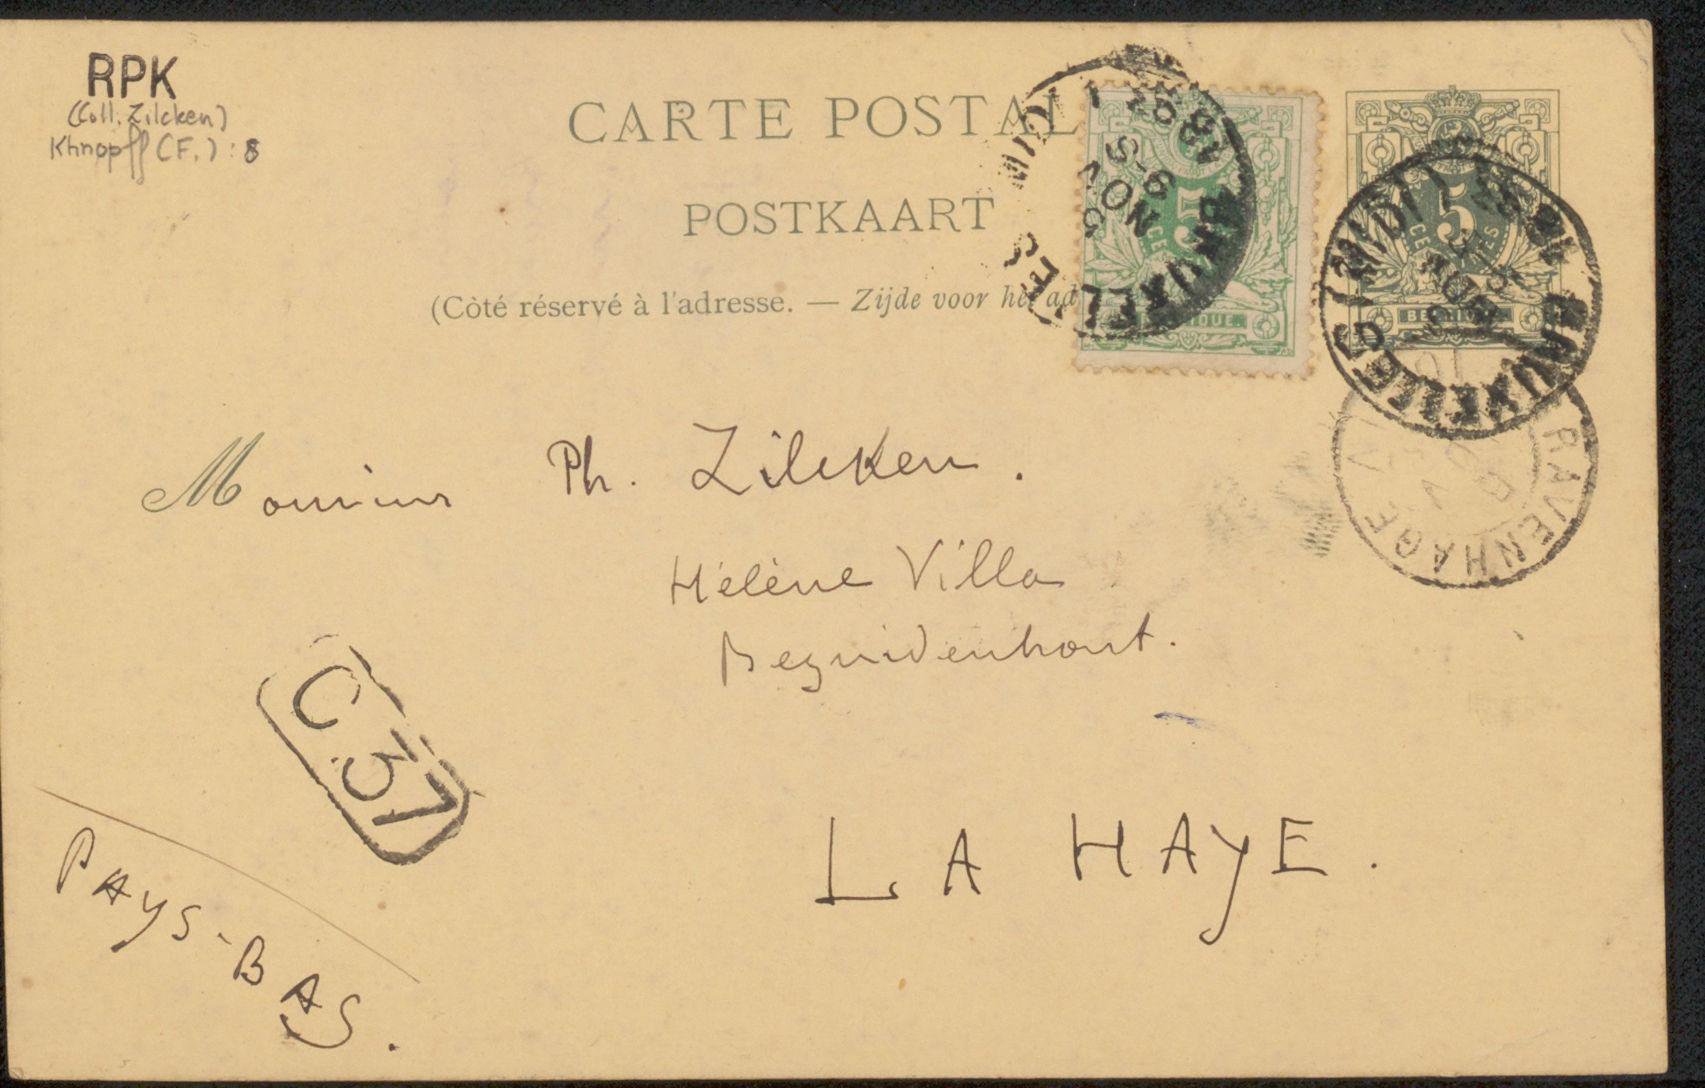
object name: postcard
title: Briefkaart aan Philip Zilcken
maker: fernand khnopff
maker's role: draughtsman, print maker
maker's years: 1858-1921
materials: cardboard, ink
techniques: pen, writing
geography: brussels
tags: the hague, painter, draughtsman, philip zilcken, drawing, exhibition ~ art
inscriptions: collector's mark: ‘RPK’